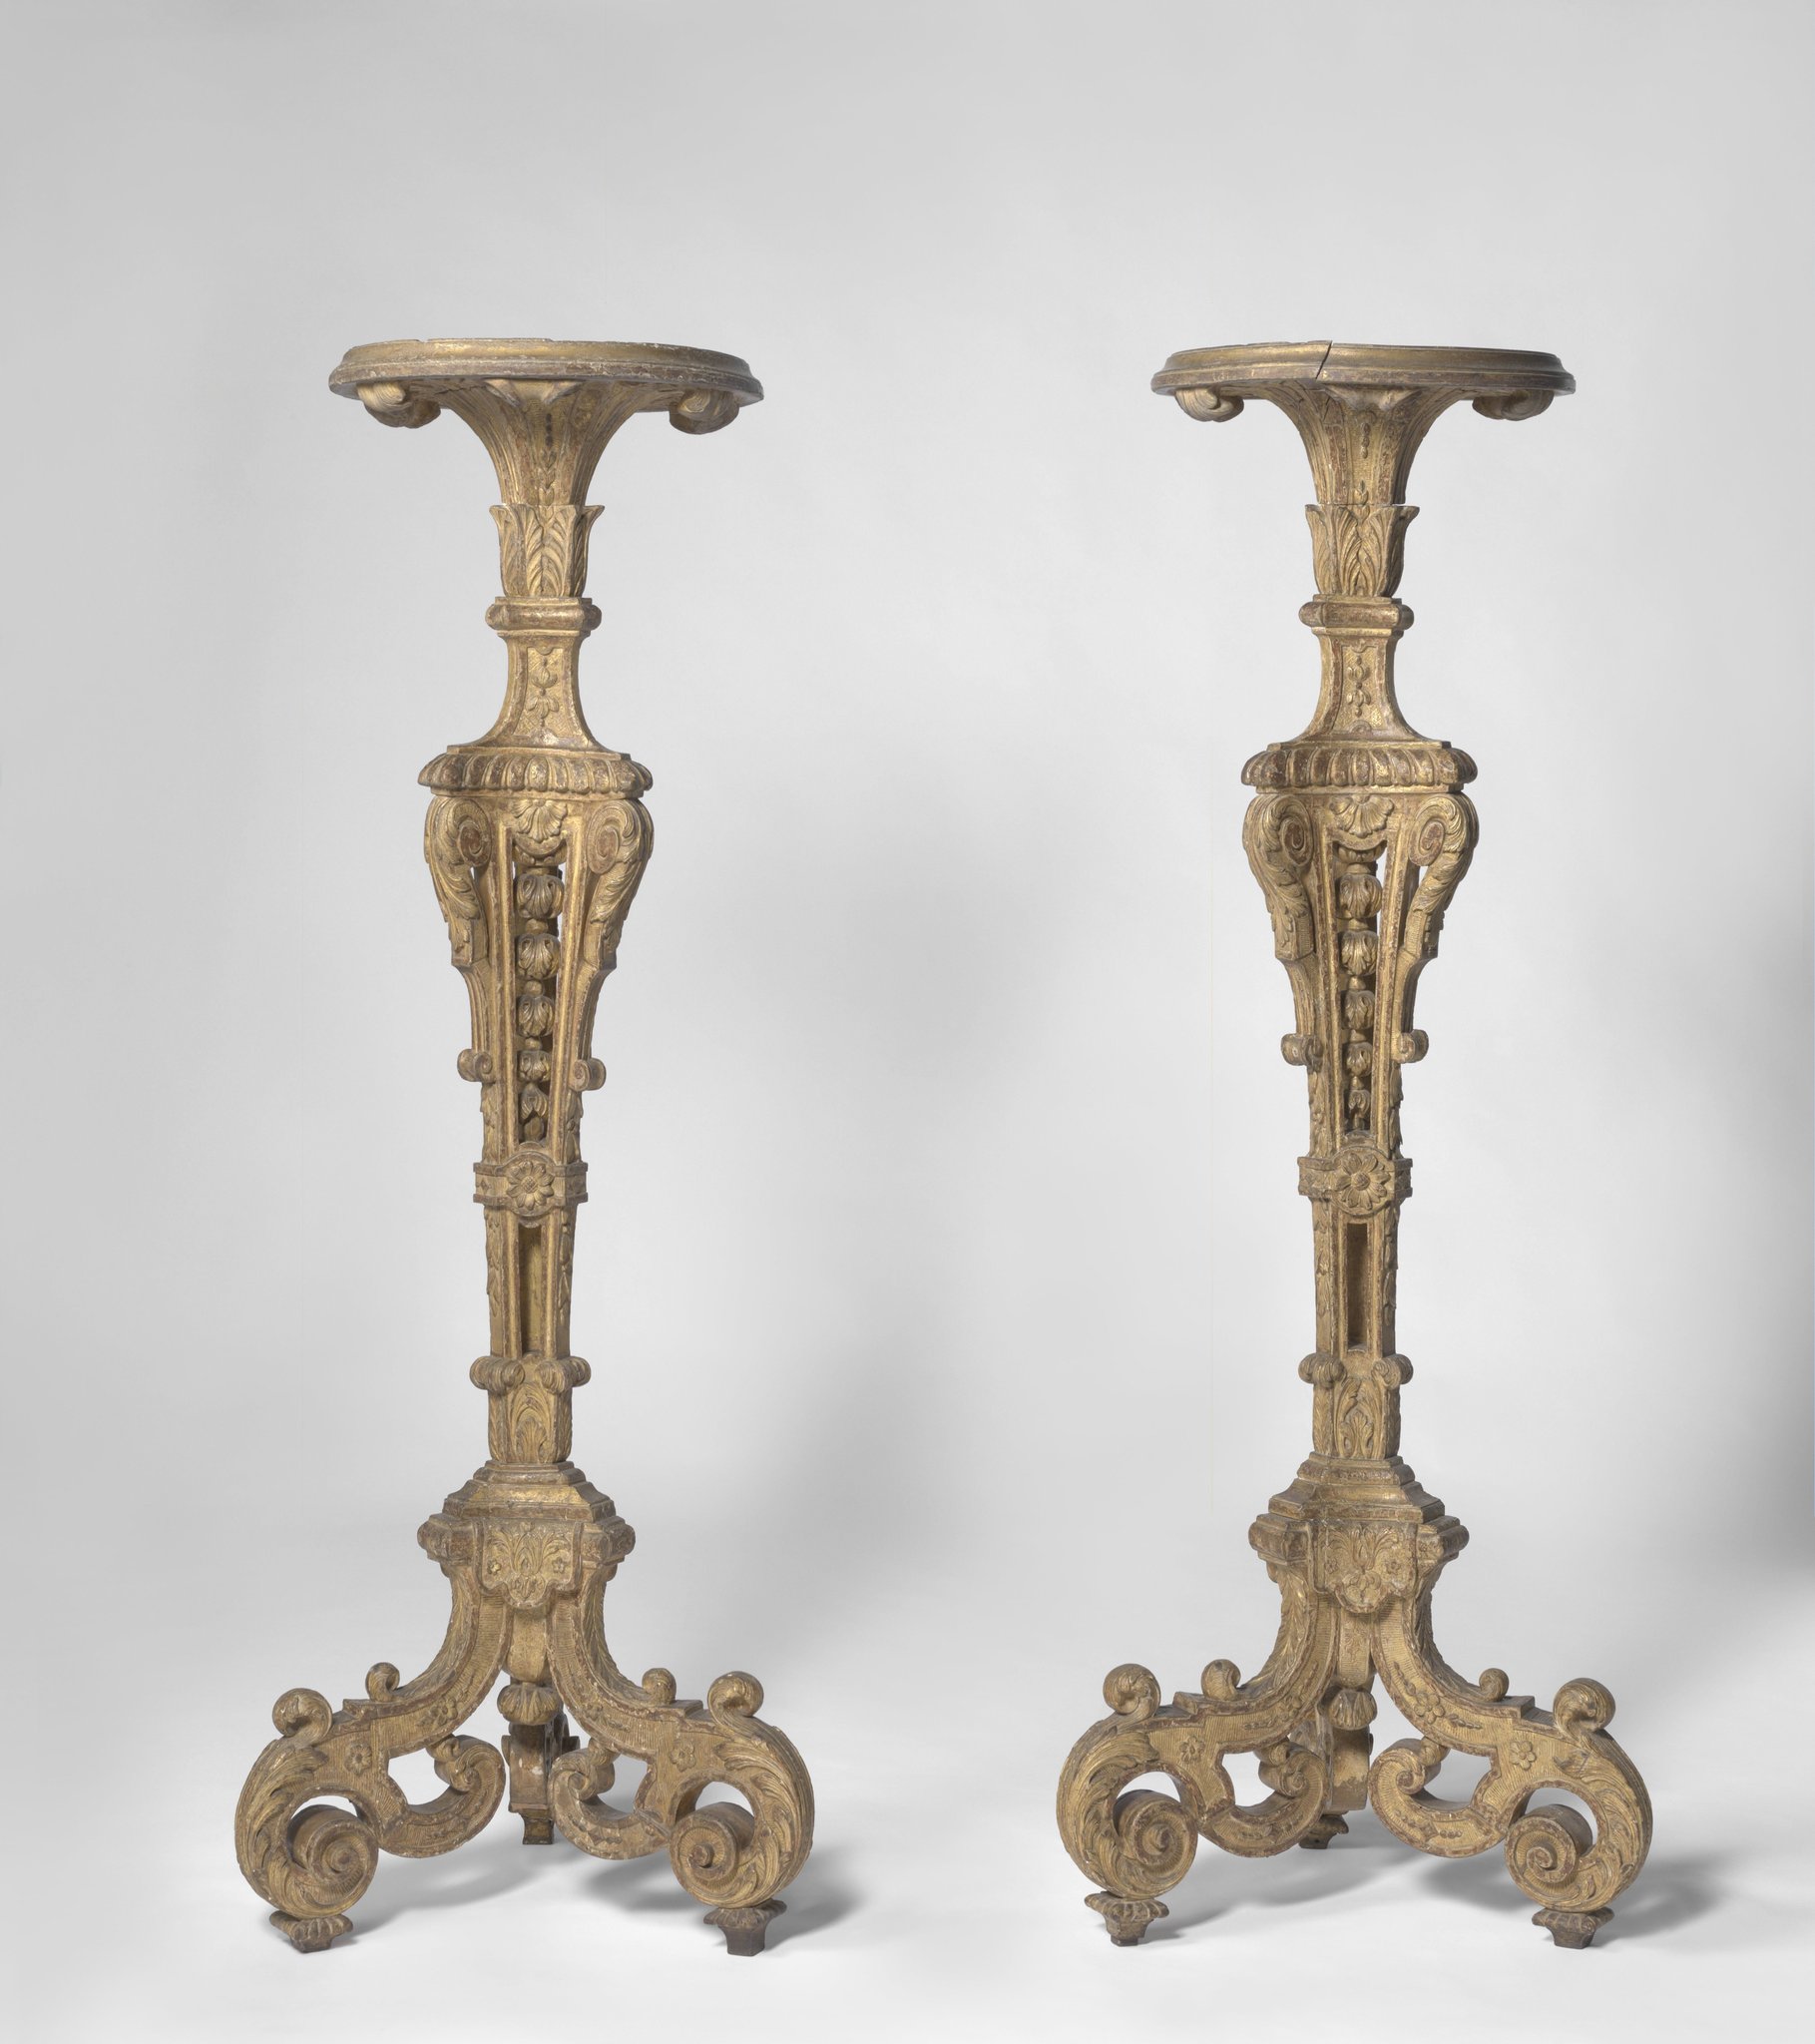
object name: furniture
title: Two Candlestands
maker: Anonymous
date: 1685-1700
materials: wood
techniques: gilding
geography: paris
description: Large candlestands of this type served to support candelabra for three or more candles. They stood in the corners of sumptuously furnished interiors, or sometimes in larger series along galleries. At the end of the seventeenth century large numbers of comparable candlestands were delivered for the palace at Versailles. The French model was also copied in England and the Netherlands.